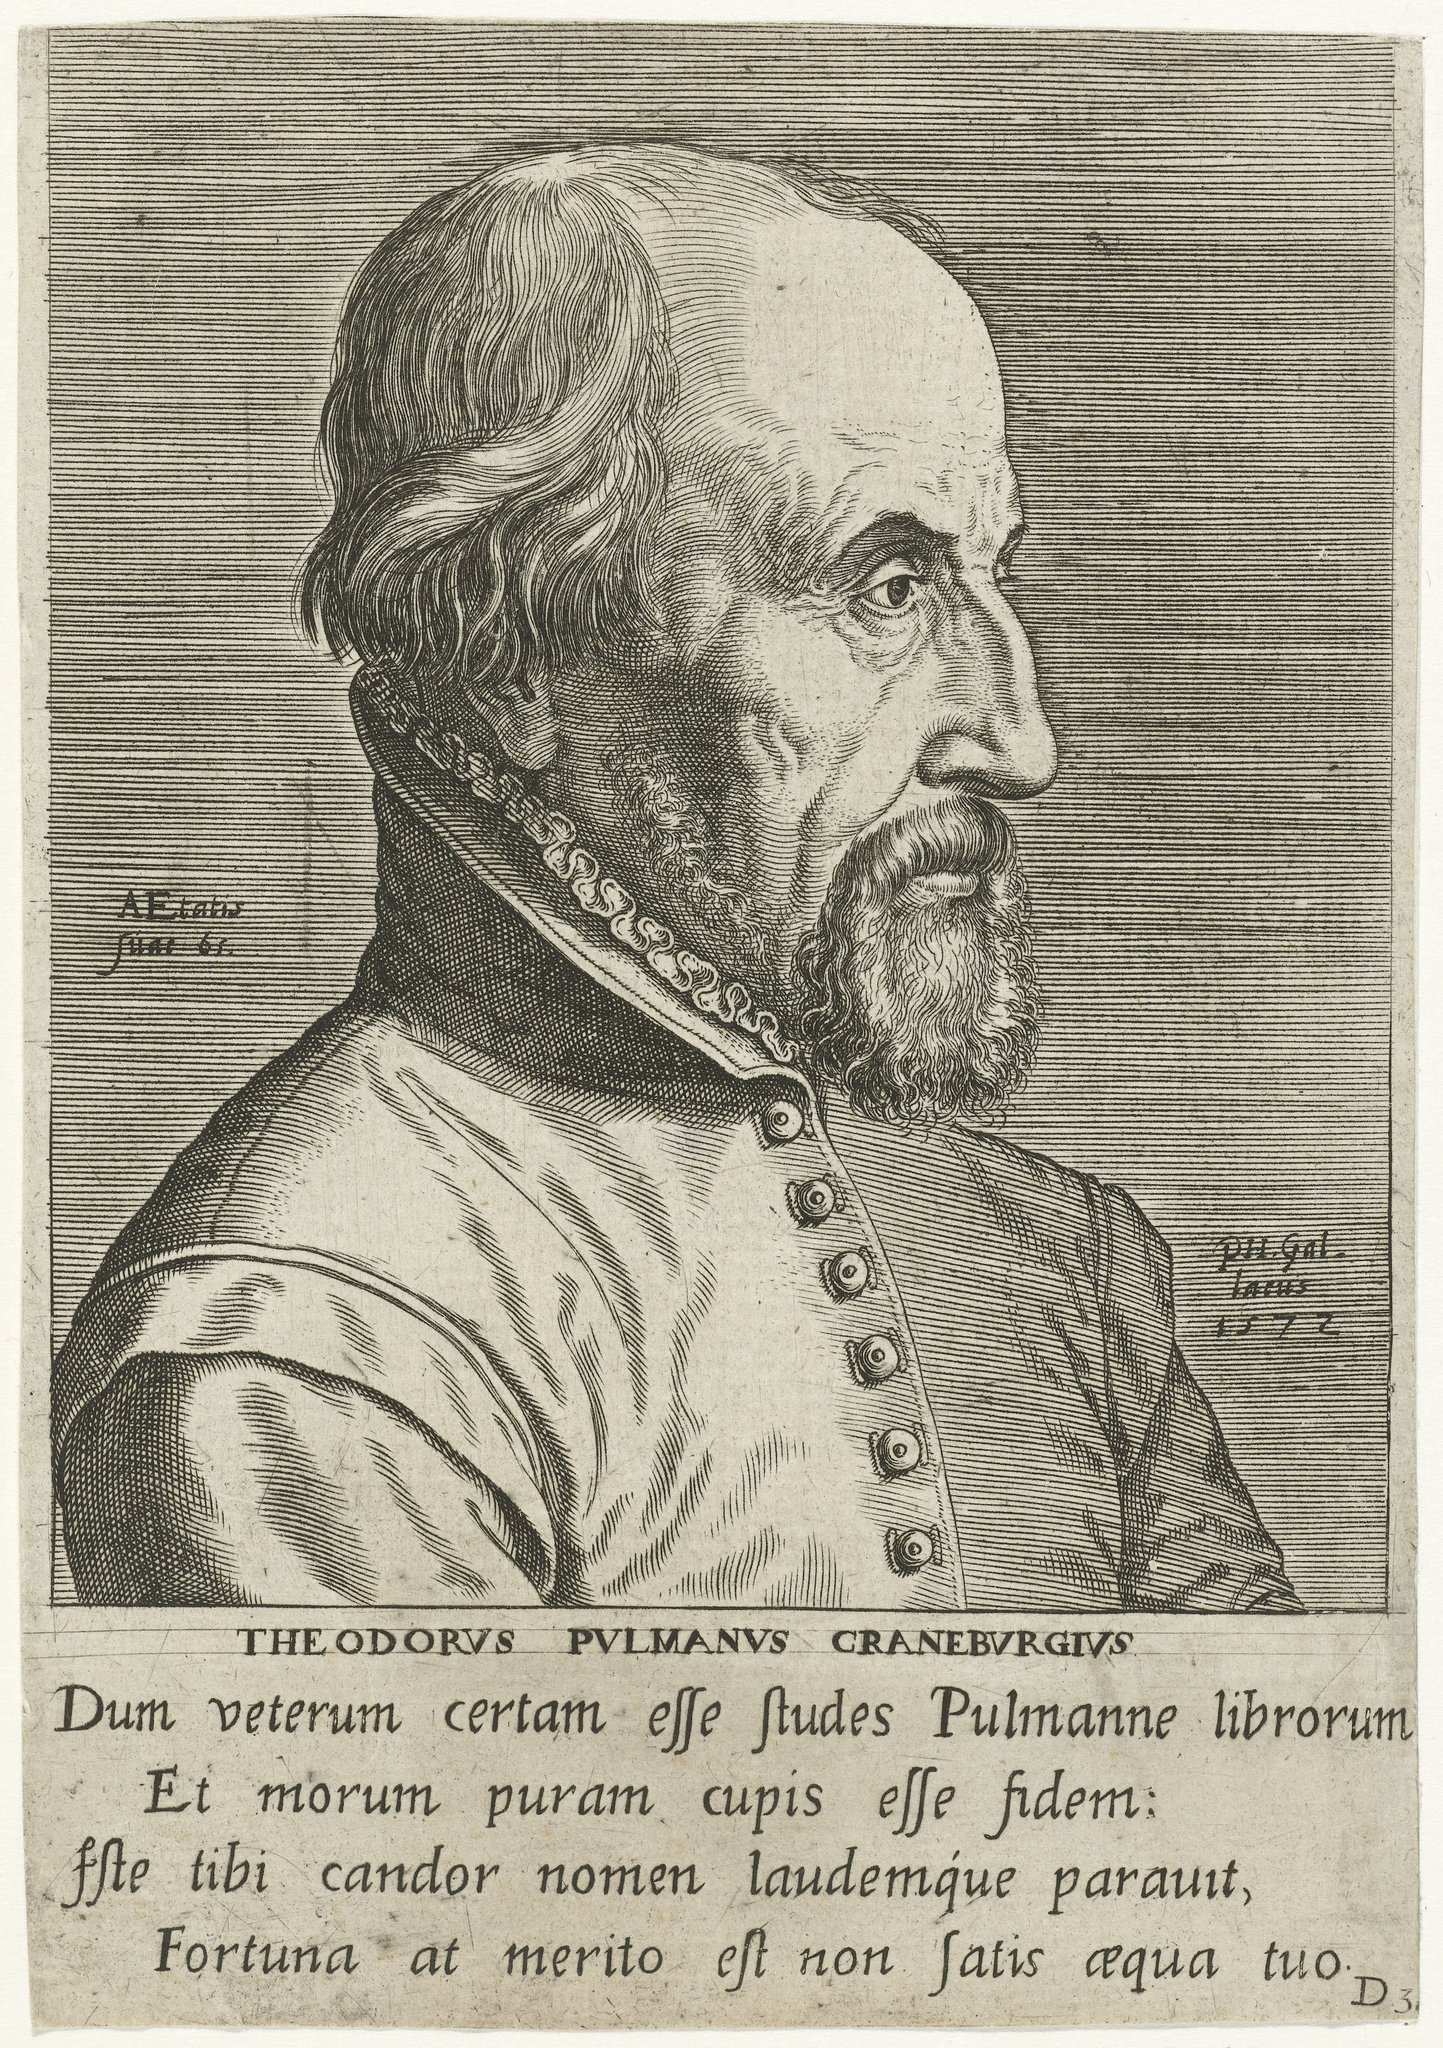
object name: print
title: Theodorvs Pvlmanvs Cranebvrgivs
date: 1572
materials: paper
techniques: engraving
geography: antwerp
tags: kranenburg, schrijver, theodoor poelman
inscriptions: collector's mark: Lugt 2228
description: Portret van Theodoor Poelman, schrijver en humanist. Profiel naar rechts. Genummerd D3. De prent heeft een Latijns onderschrift en maakt deel uit van een serie van beroemde Europese geleerden.